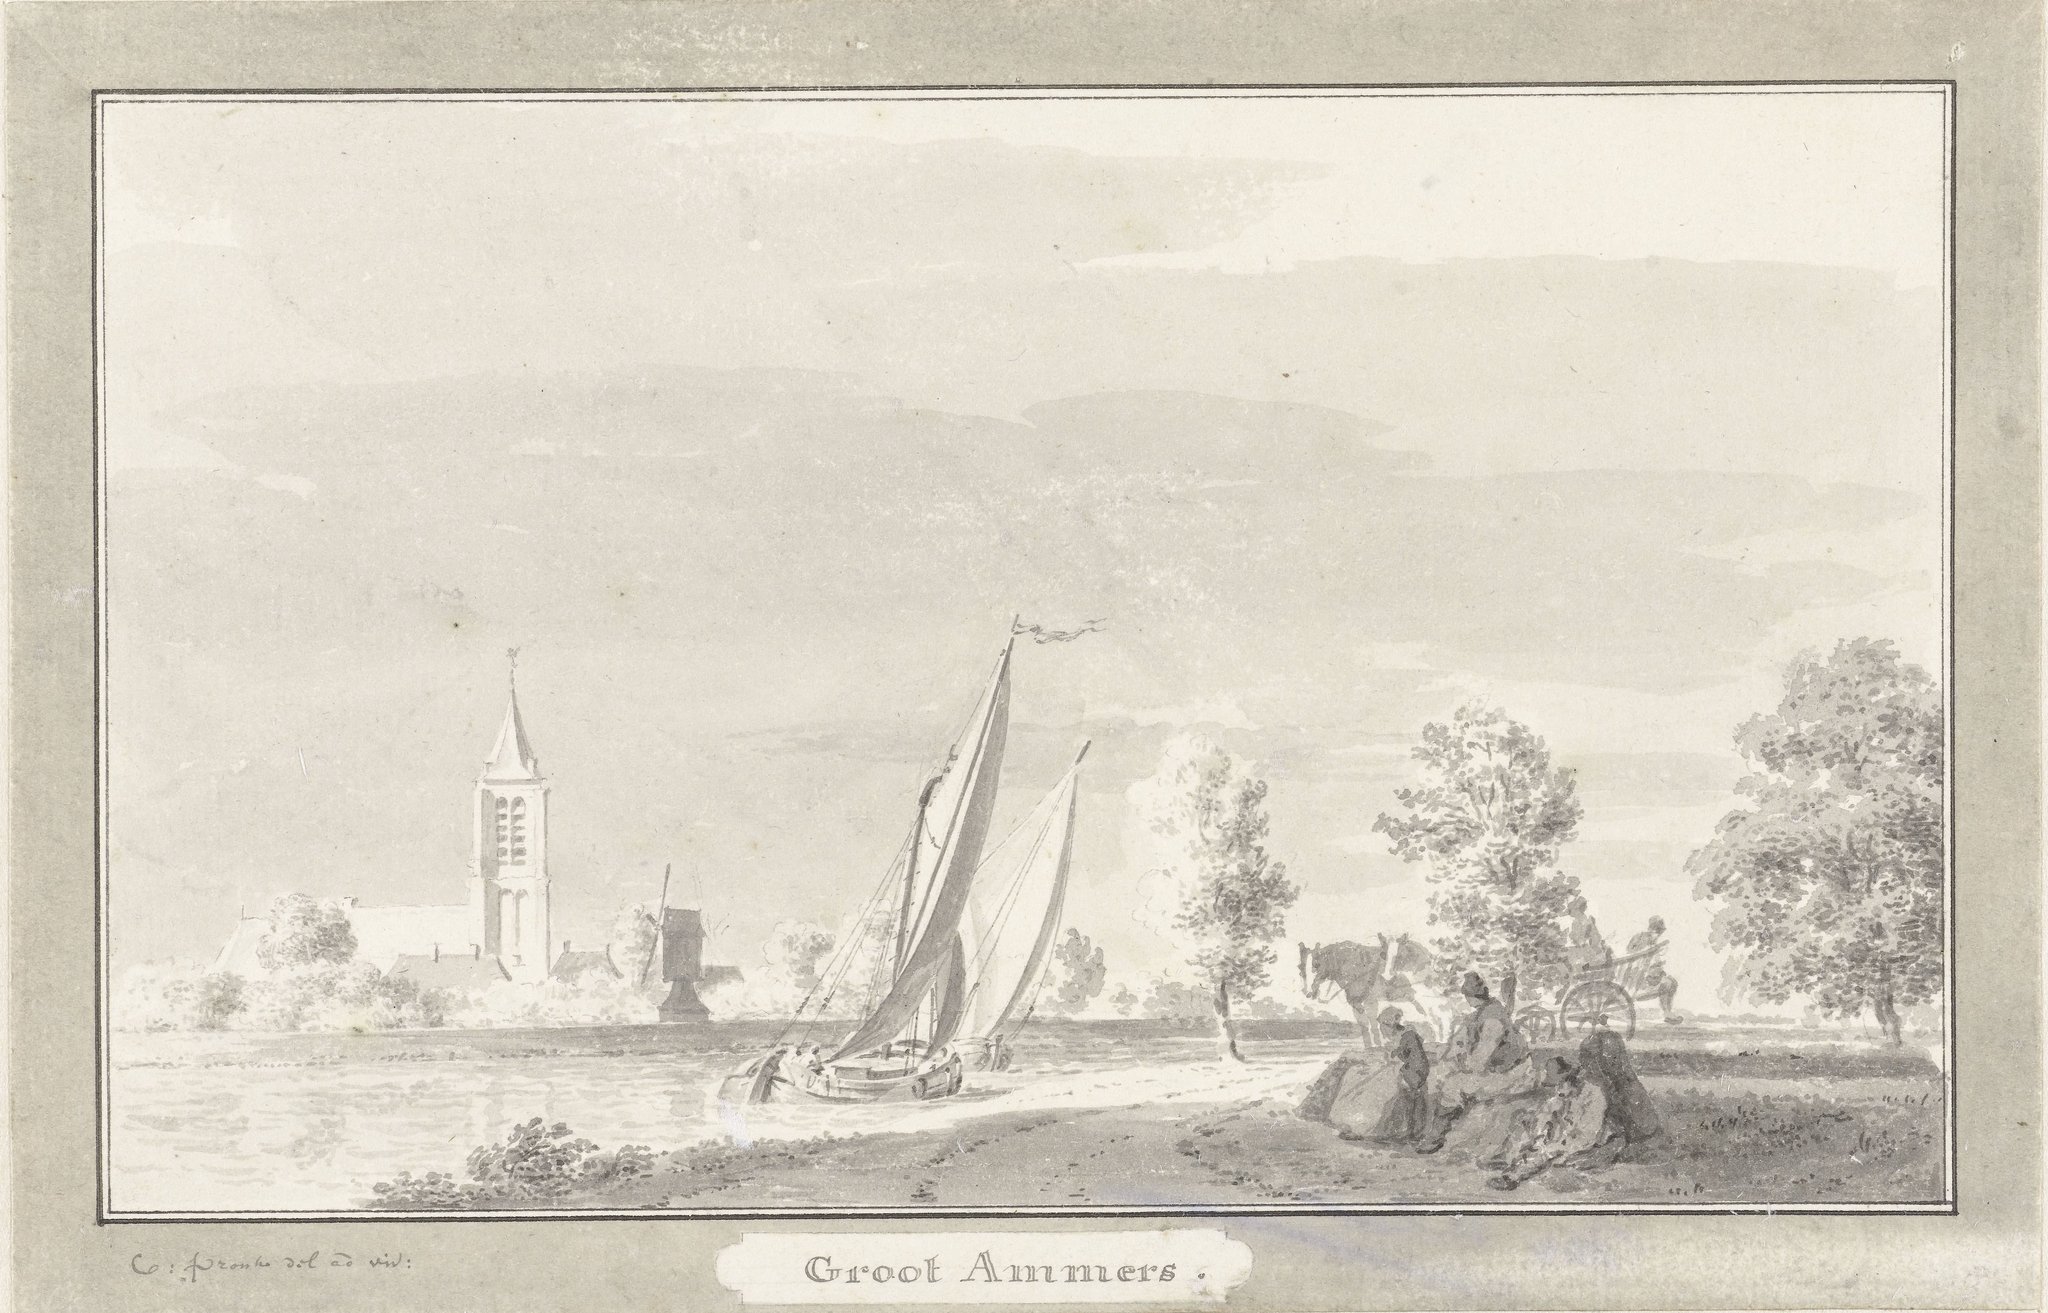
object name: drawing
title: Gezicht op het dorp Groot-Ammers over de Lek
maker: cornelis pronk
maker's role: draughtsman, painter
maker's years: 1691-1759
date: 1720-1740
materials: ink, paper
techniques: brush, pen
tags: prospect of village, silhouette of village, sailing-ship, sailing-boat, church (exterior)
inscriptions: inscription: ‘C: pronk del ad viv: / Groot Ammers’